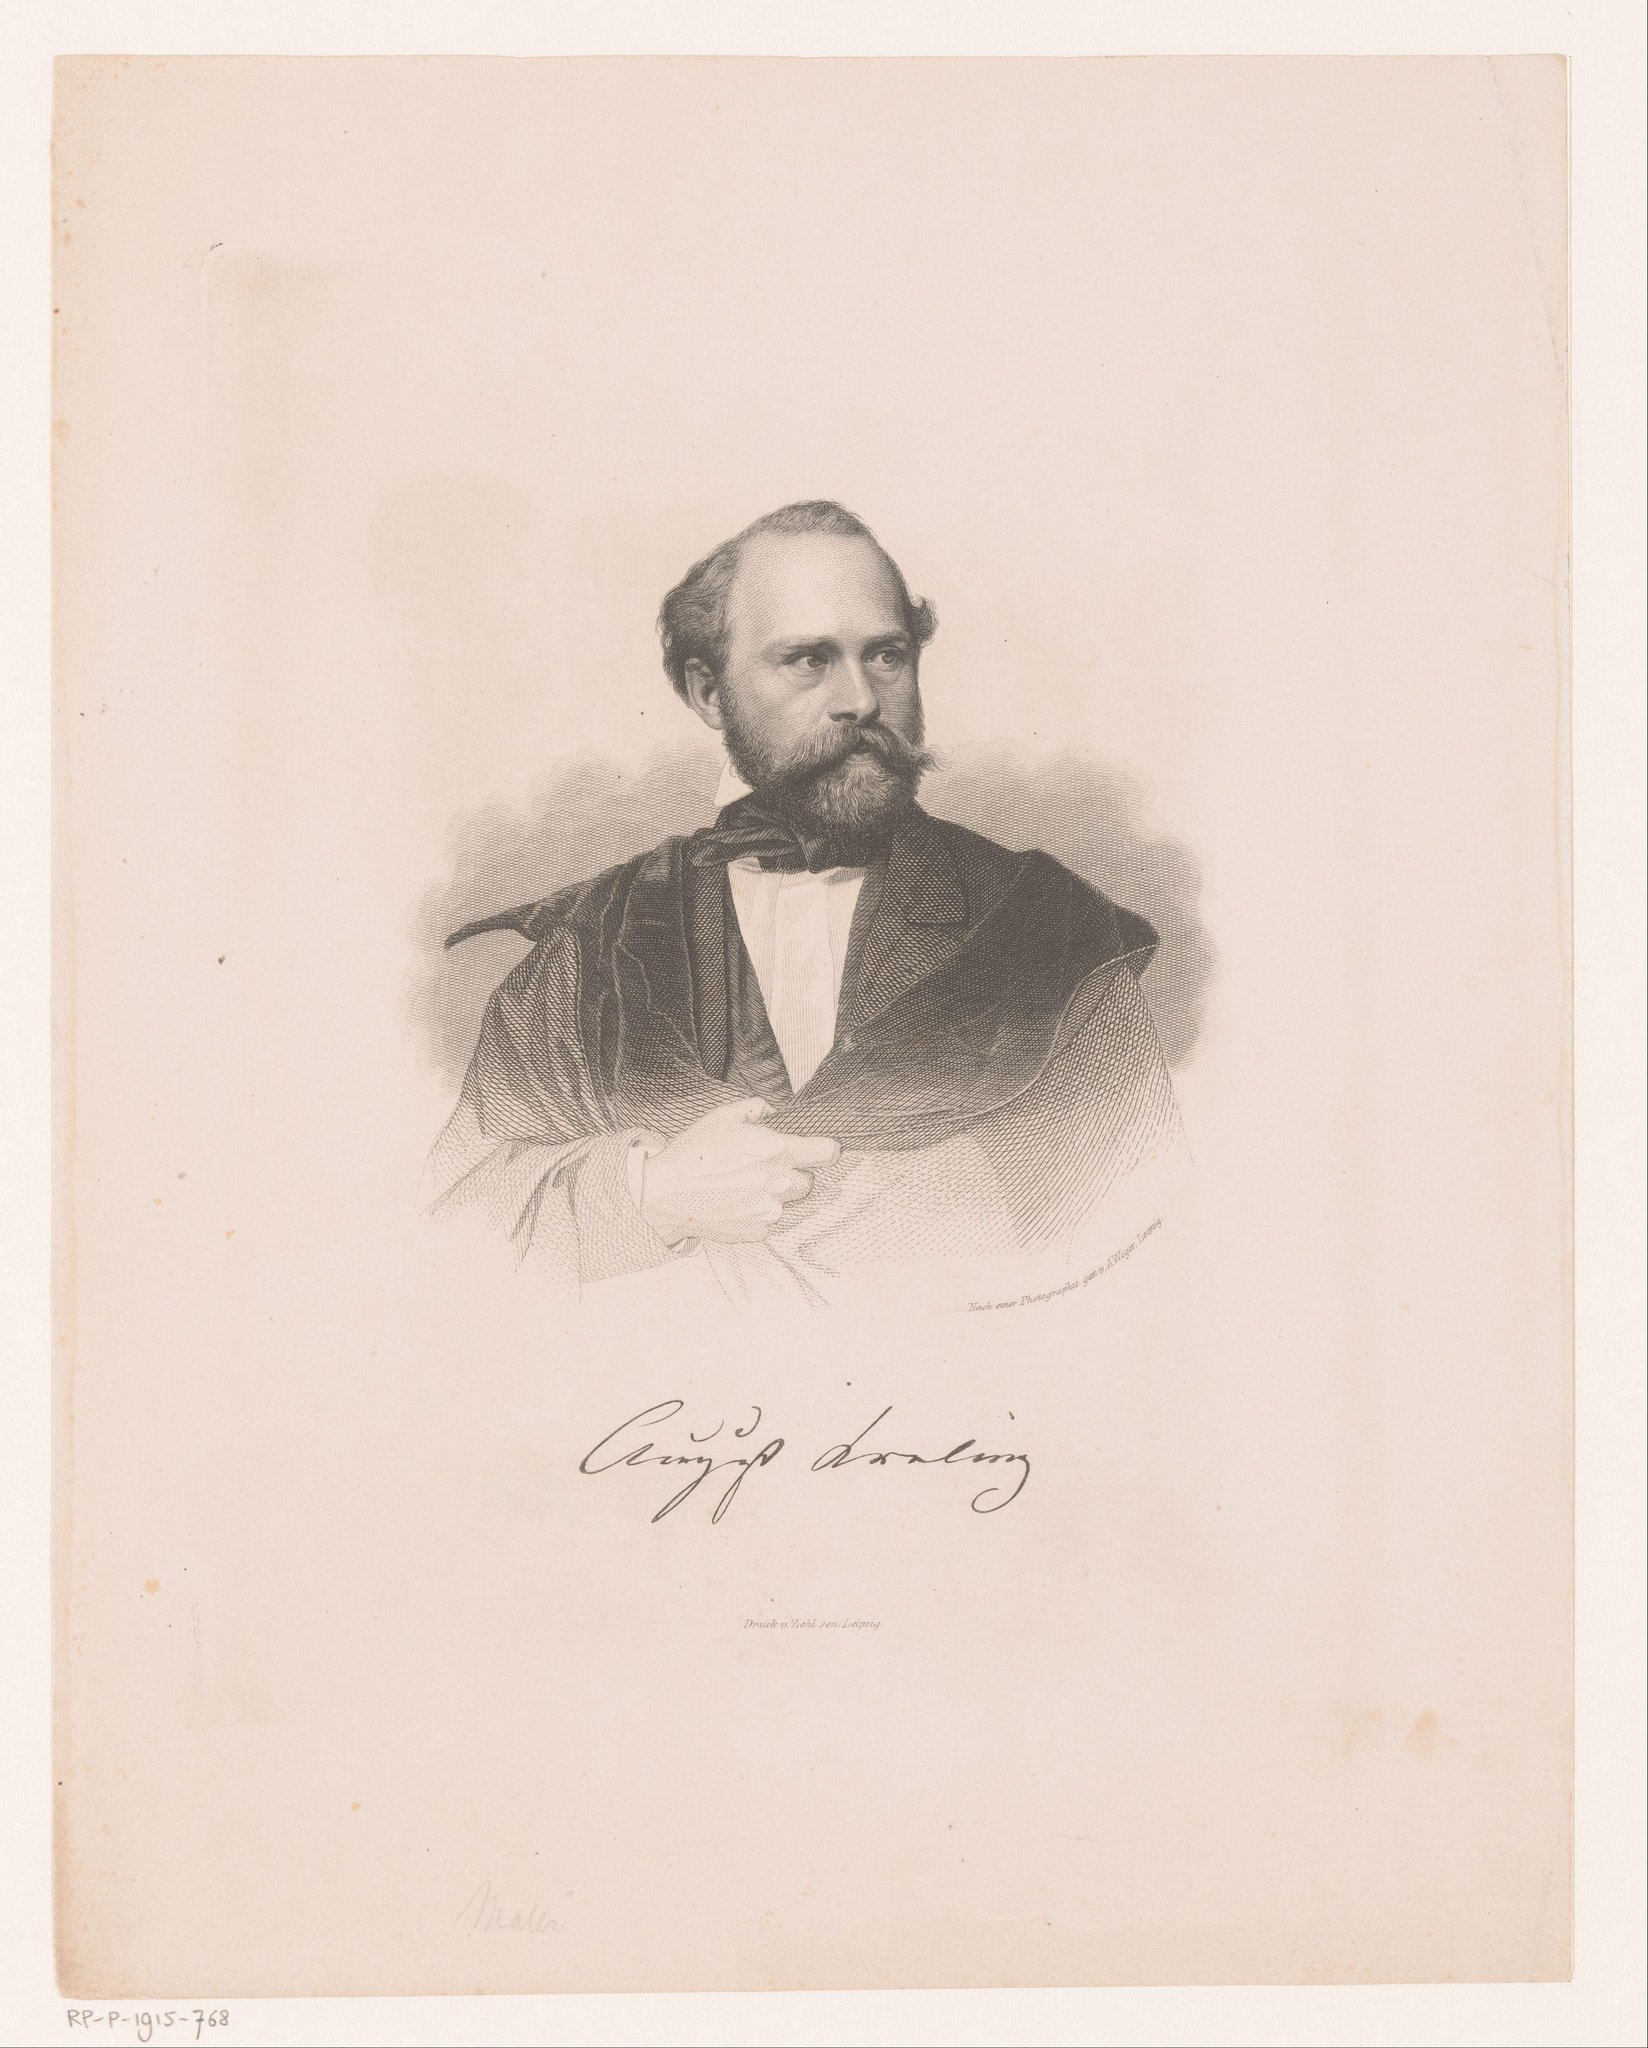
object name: print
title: Portret van August, Ritter von Kreling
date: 1860-1892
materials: paper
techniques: engraving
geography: leipzig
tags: painter, sculptor, historical persons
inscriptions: collector's mark: Lugt 2228